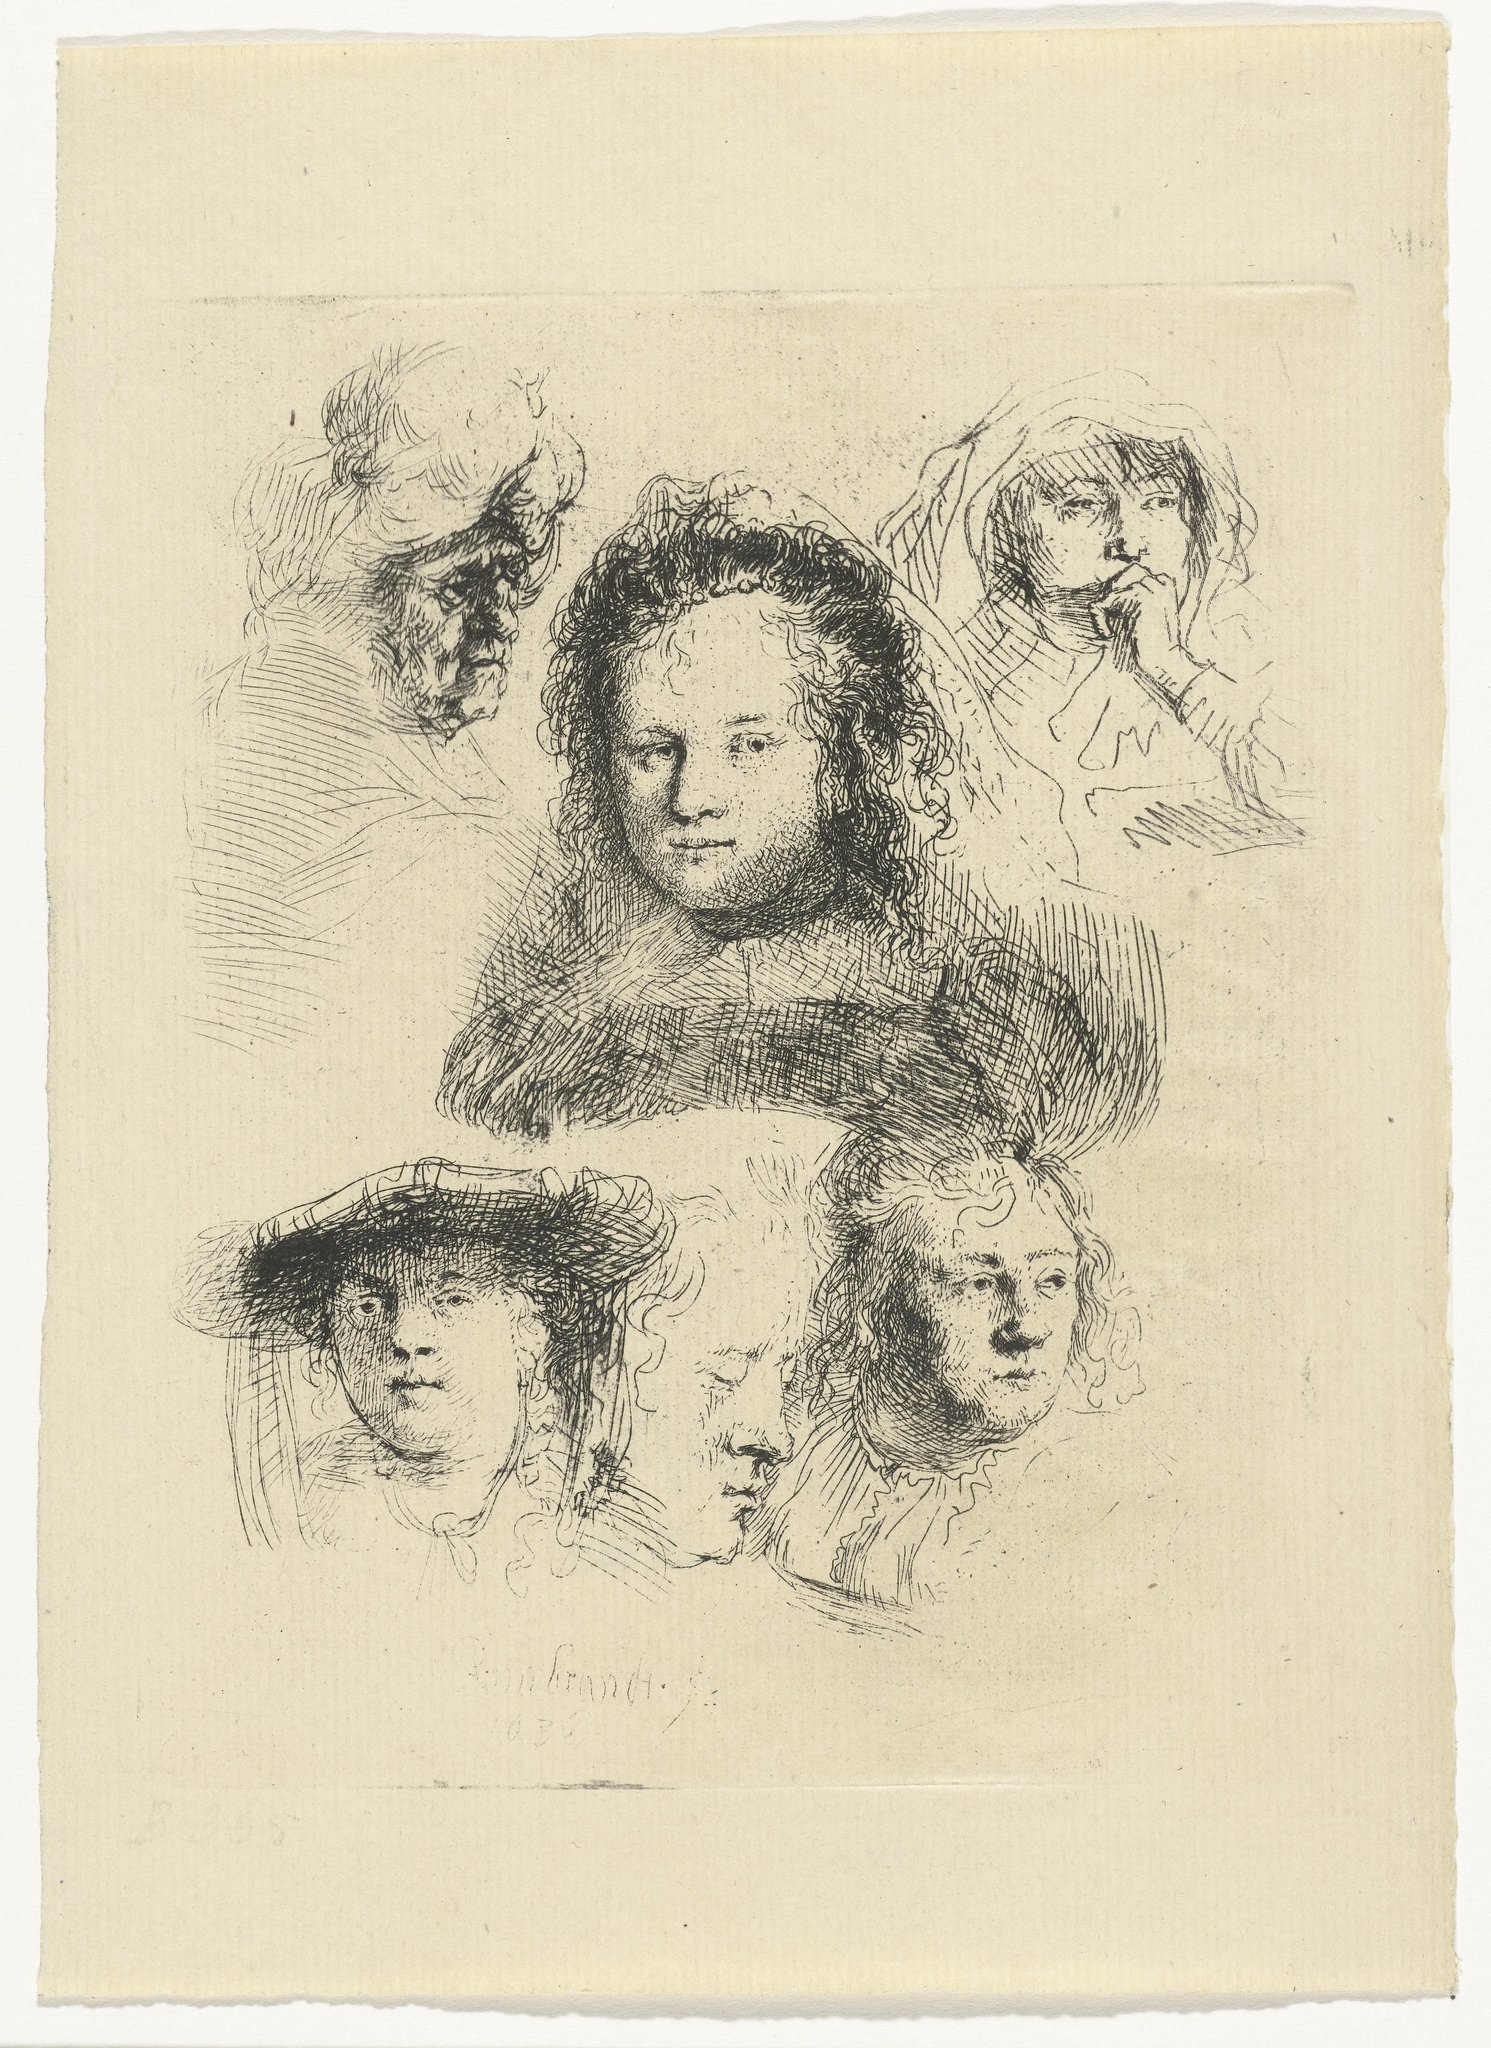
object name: print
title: Studies of the head of Saskia and others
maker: ignace-joseph de claussin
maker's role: print maker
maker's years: 1766-1844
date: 1805-1844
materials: paper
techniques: etching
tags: amsterdam, drawing, sketch, historical persons - bb - woman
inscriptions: collector's mark: Lugt 2228